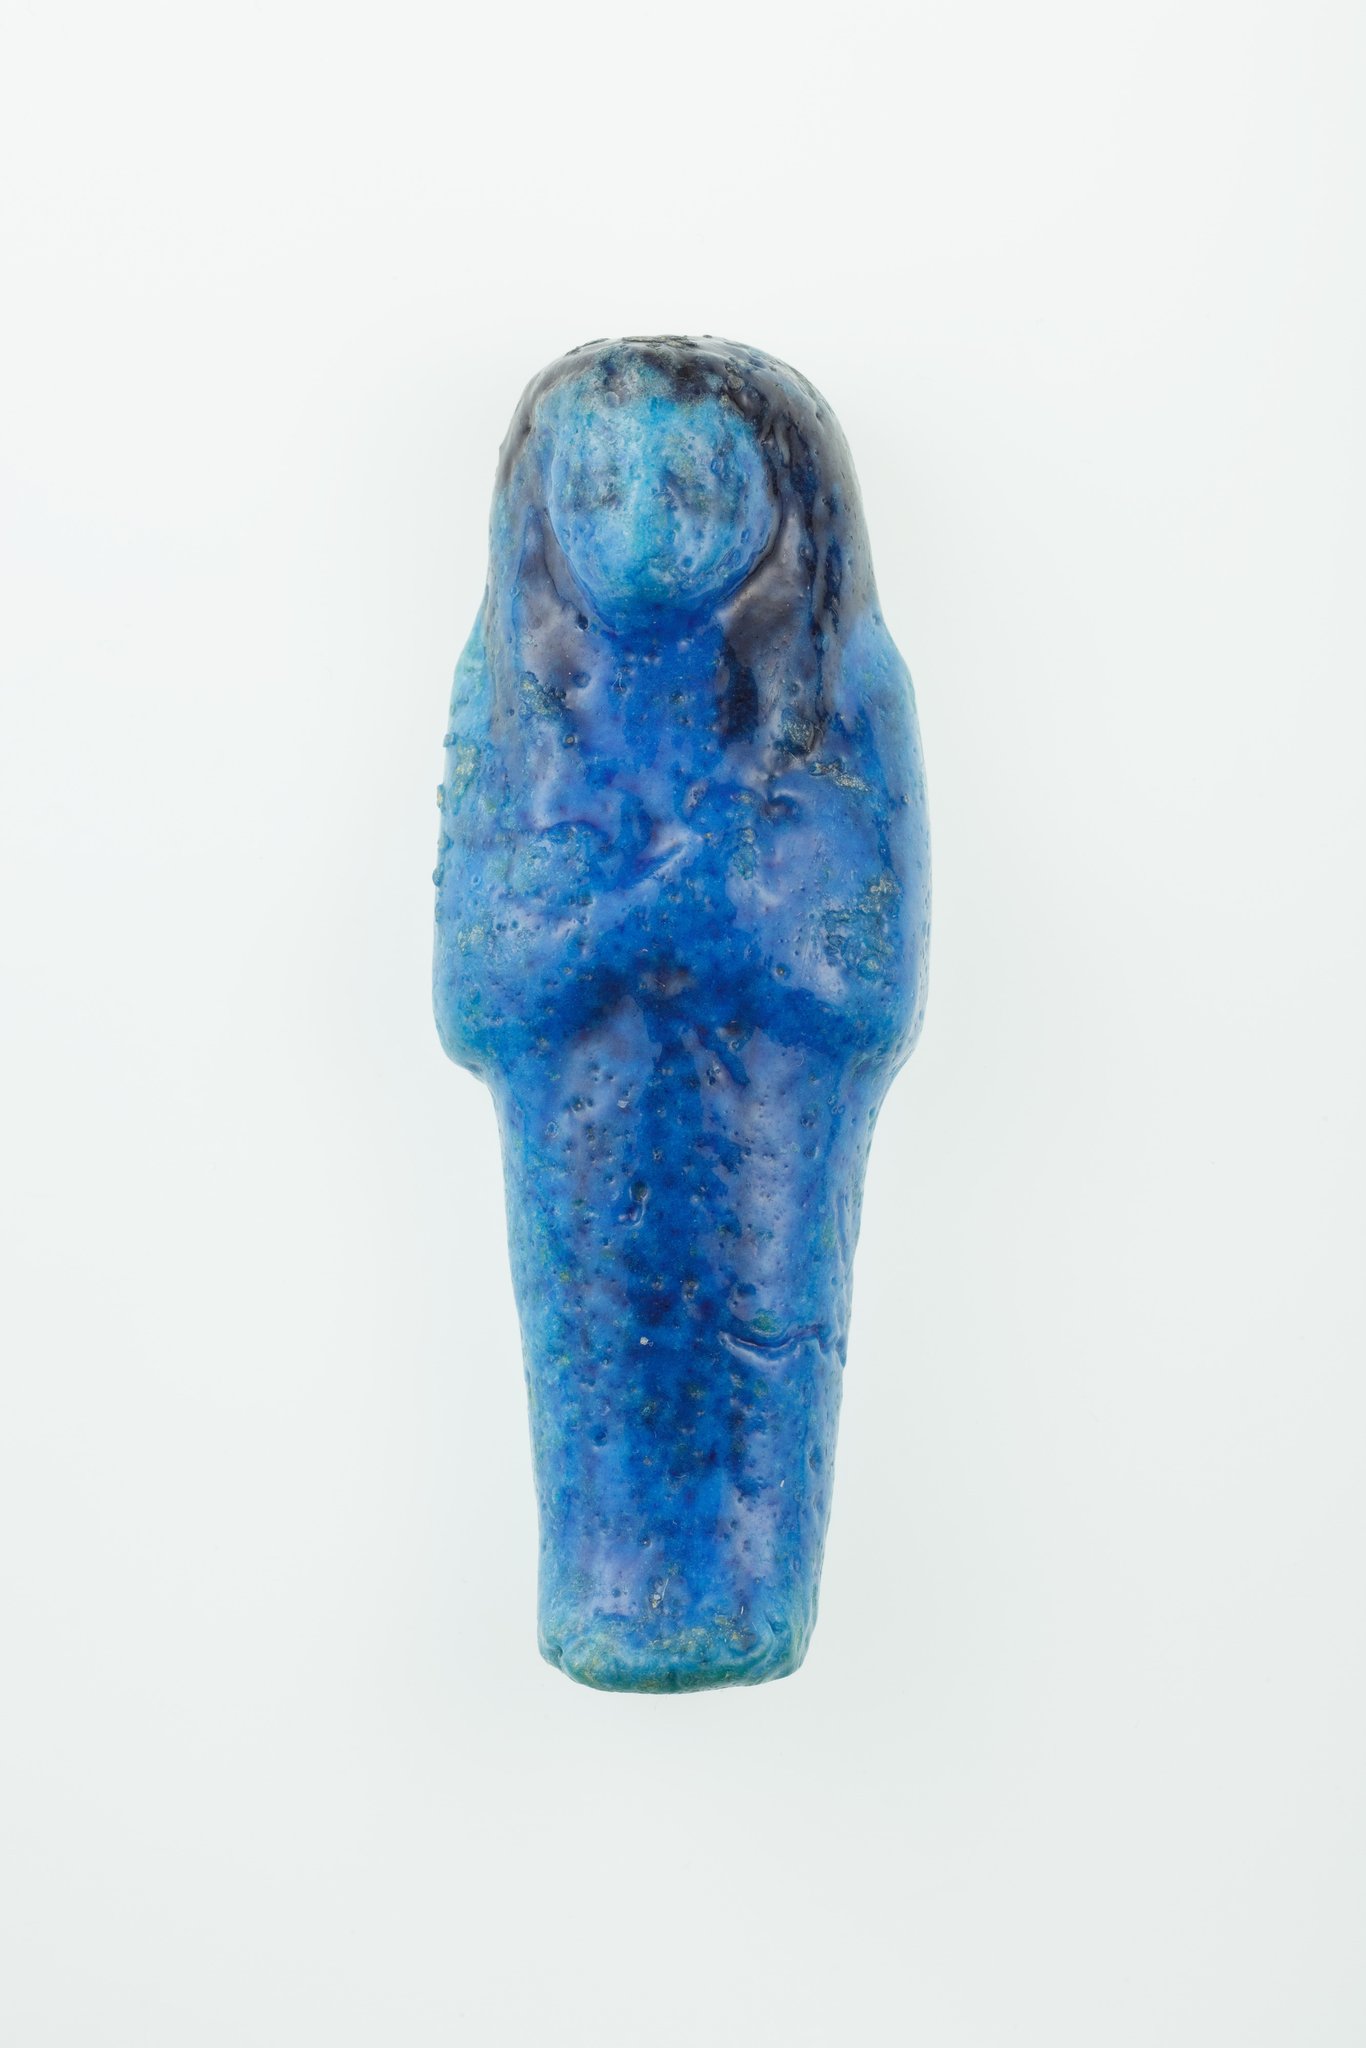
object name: shabti, worker, nauny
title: Worker Shabti of Nauny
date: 1050 BCE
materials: faience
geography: egypt